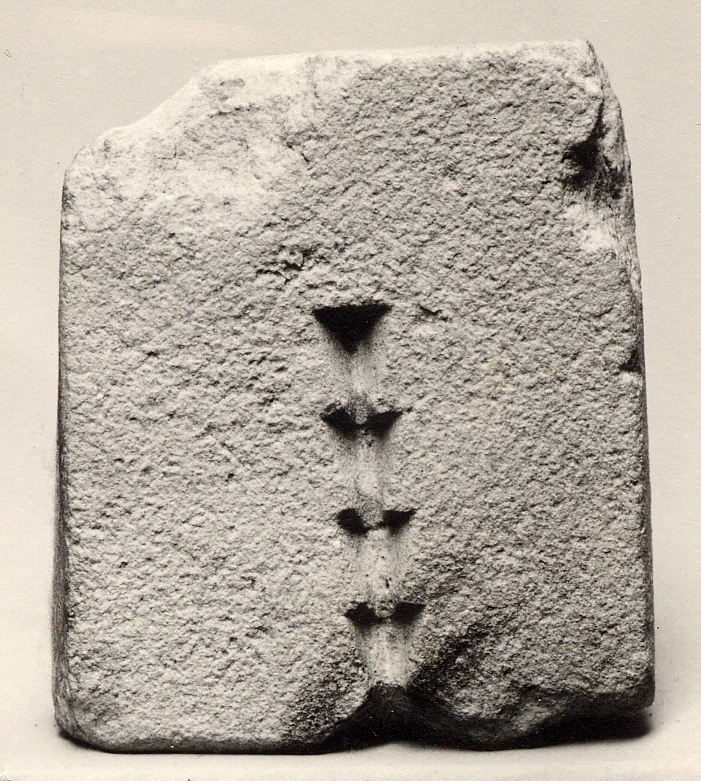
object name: mold, metalwork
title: Metalwork mould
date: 1981-1640 BCE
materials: limestone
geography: egypt